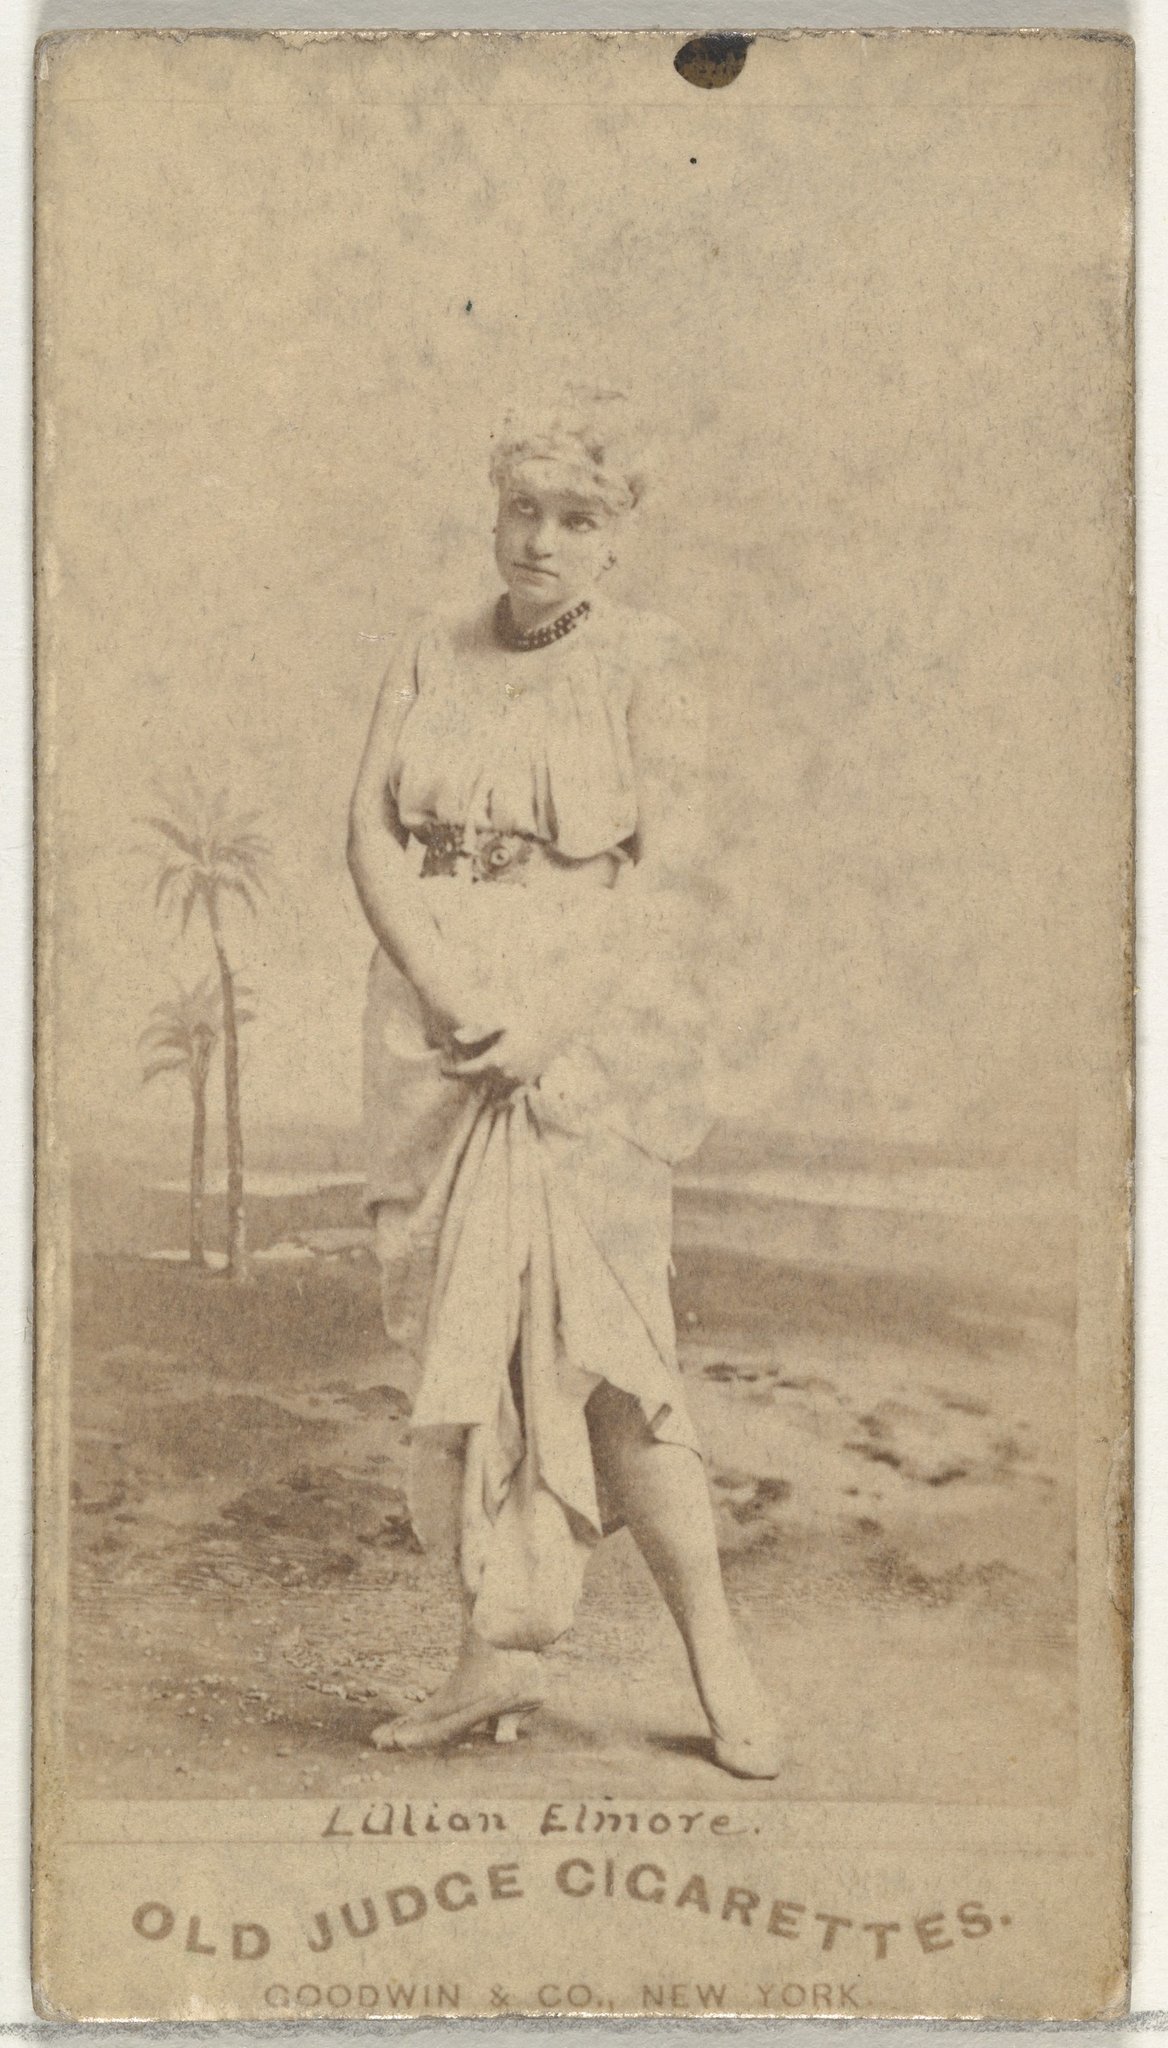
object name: photograph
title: Lillian Elmore, from the Actors and Actresses series (N171) for Old Judge Cigarettes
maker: goodwin & company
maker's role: publisher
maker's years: 1850-1950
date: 1886-1890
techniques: albumen silver print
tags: portraits,women,actresses